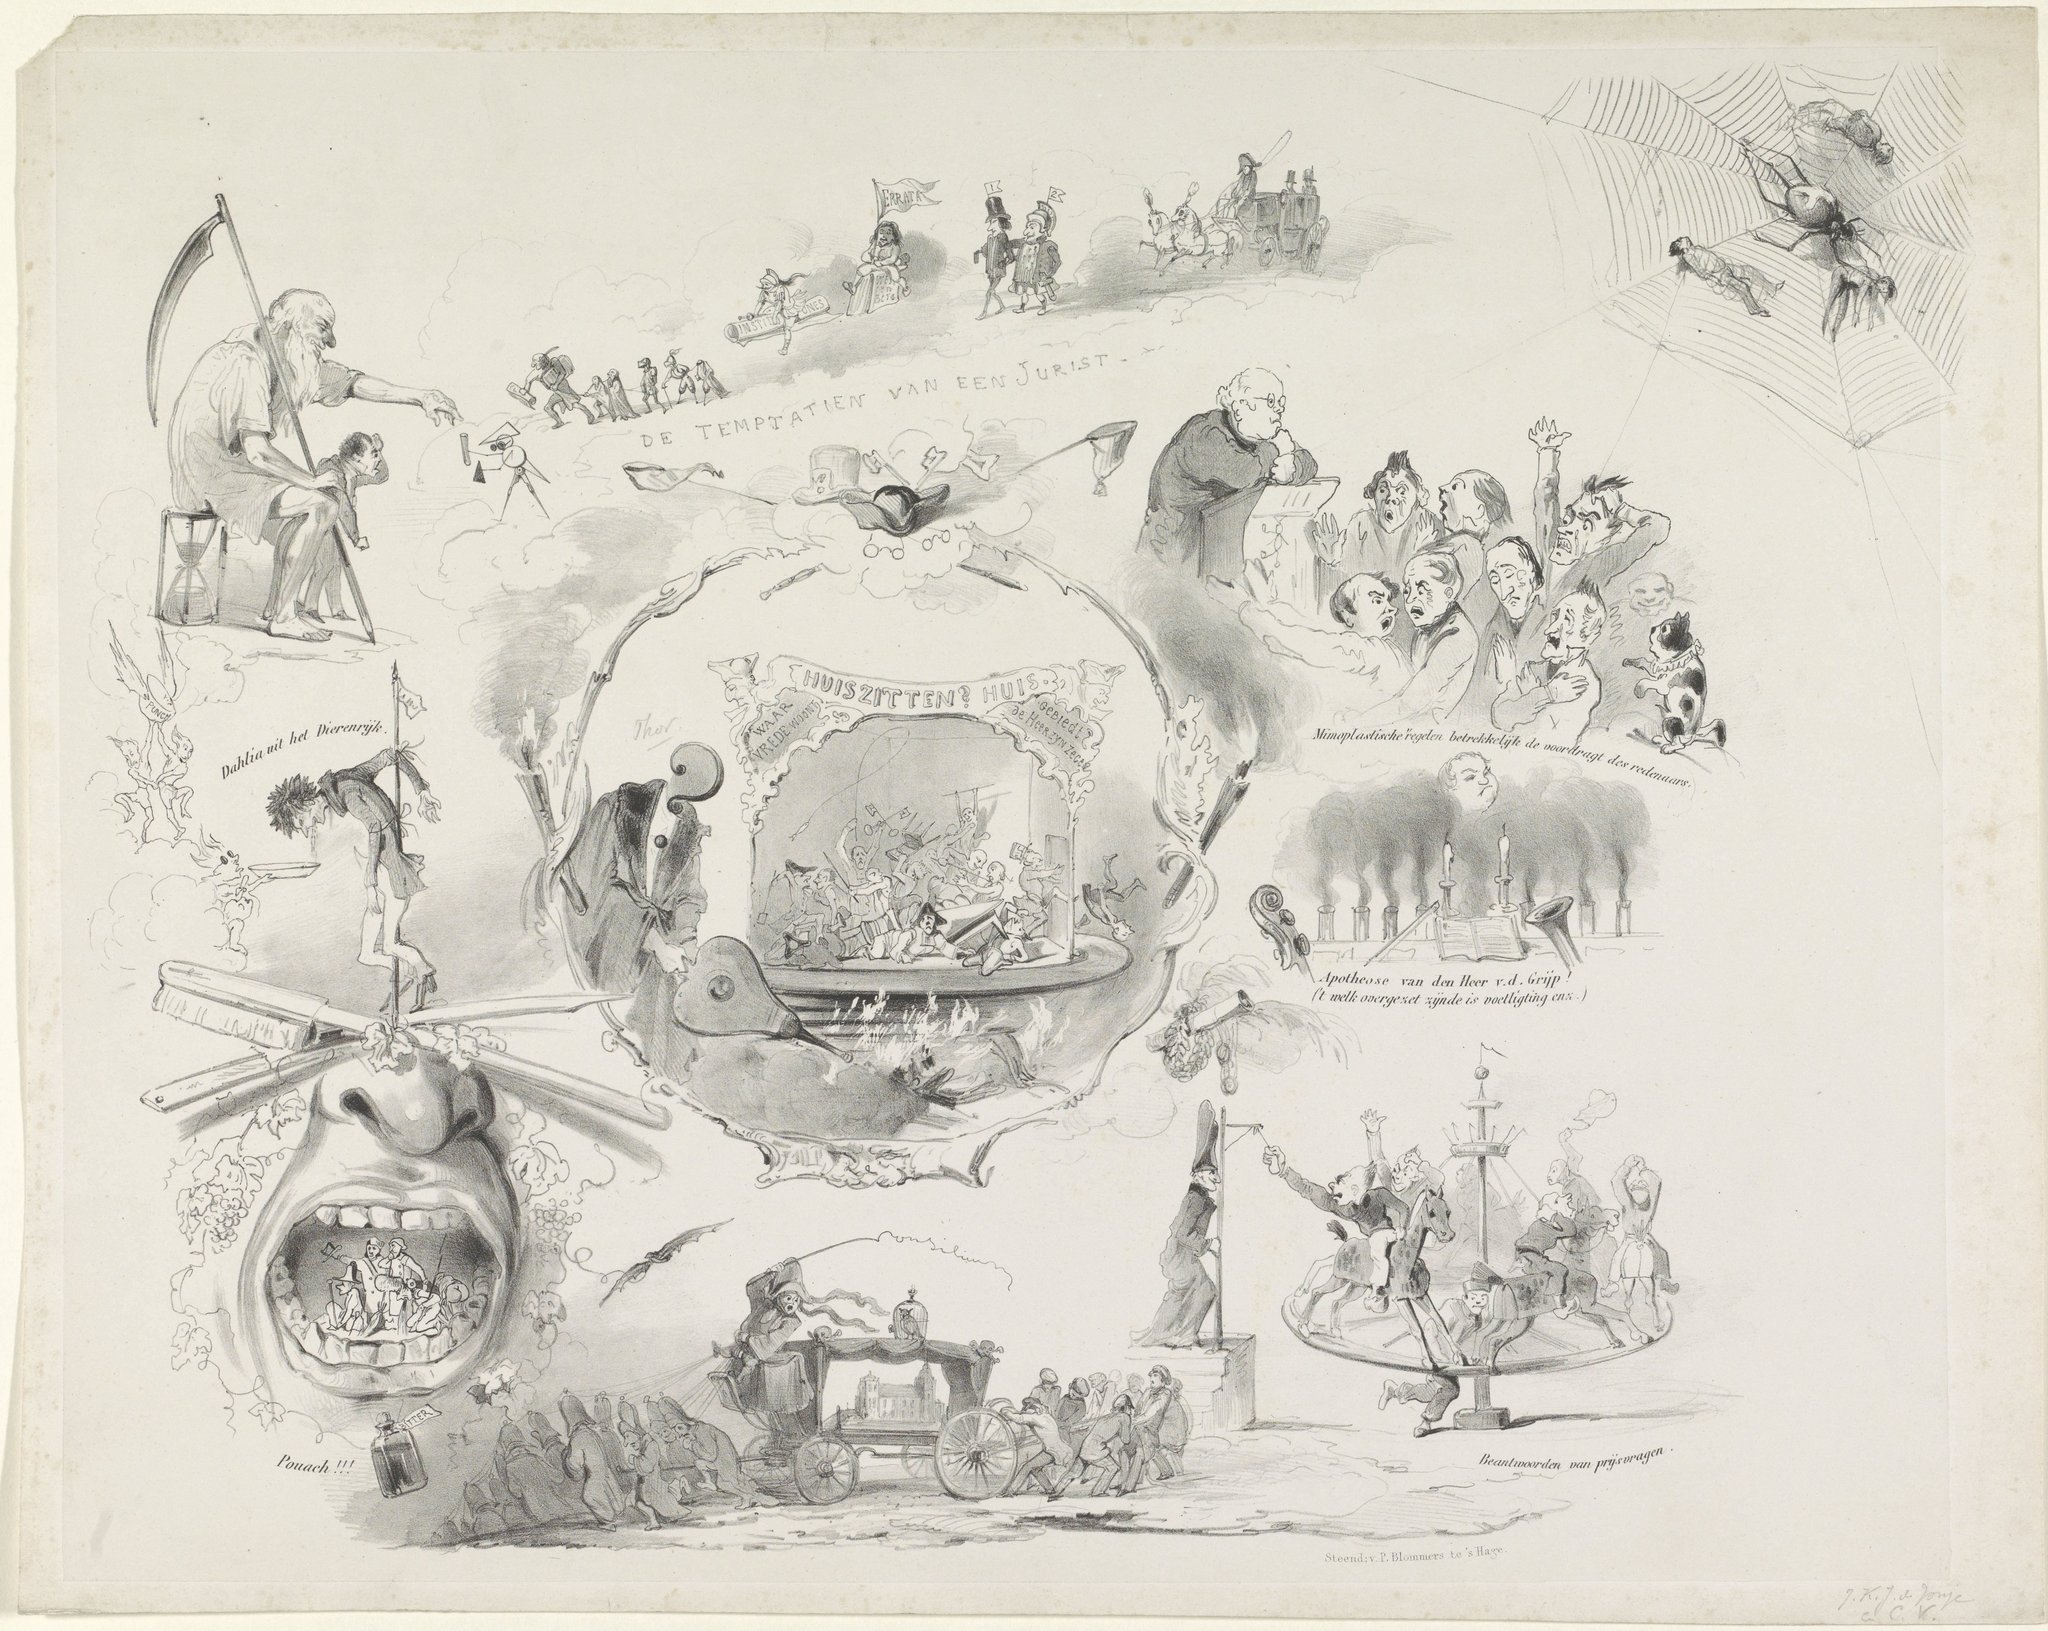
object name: cartoon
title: Spotprent uit Leidse studentenalmanak, 1849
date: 1849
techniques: printmaking, lithograph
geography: the hague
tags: student life, leiden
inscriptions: collector's mark: Lugt 2228, collector's mark: Lugt 2760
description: Spotprent uit de studentenalmanak van de Universiteit van Leiden van het jaar 1849. Centraal het bestuur van het Leidsche Huiszittenhuis omringd door scènes van professoren en studentenleven.